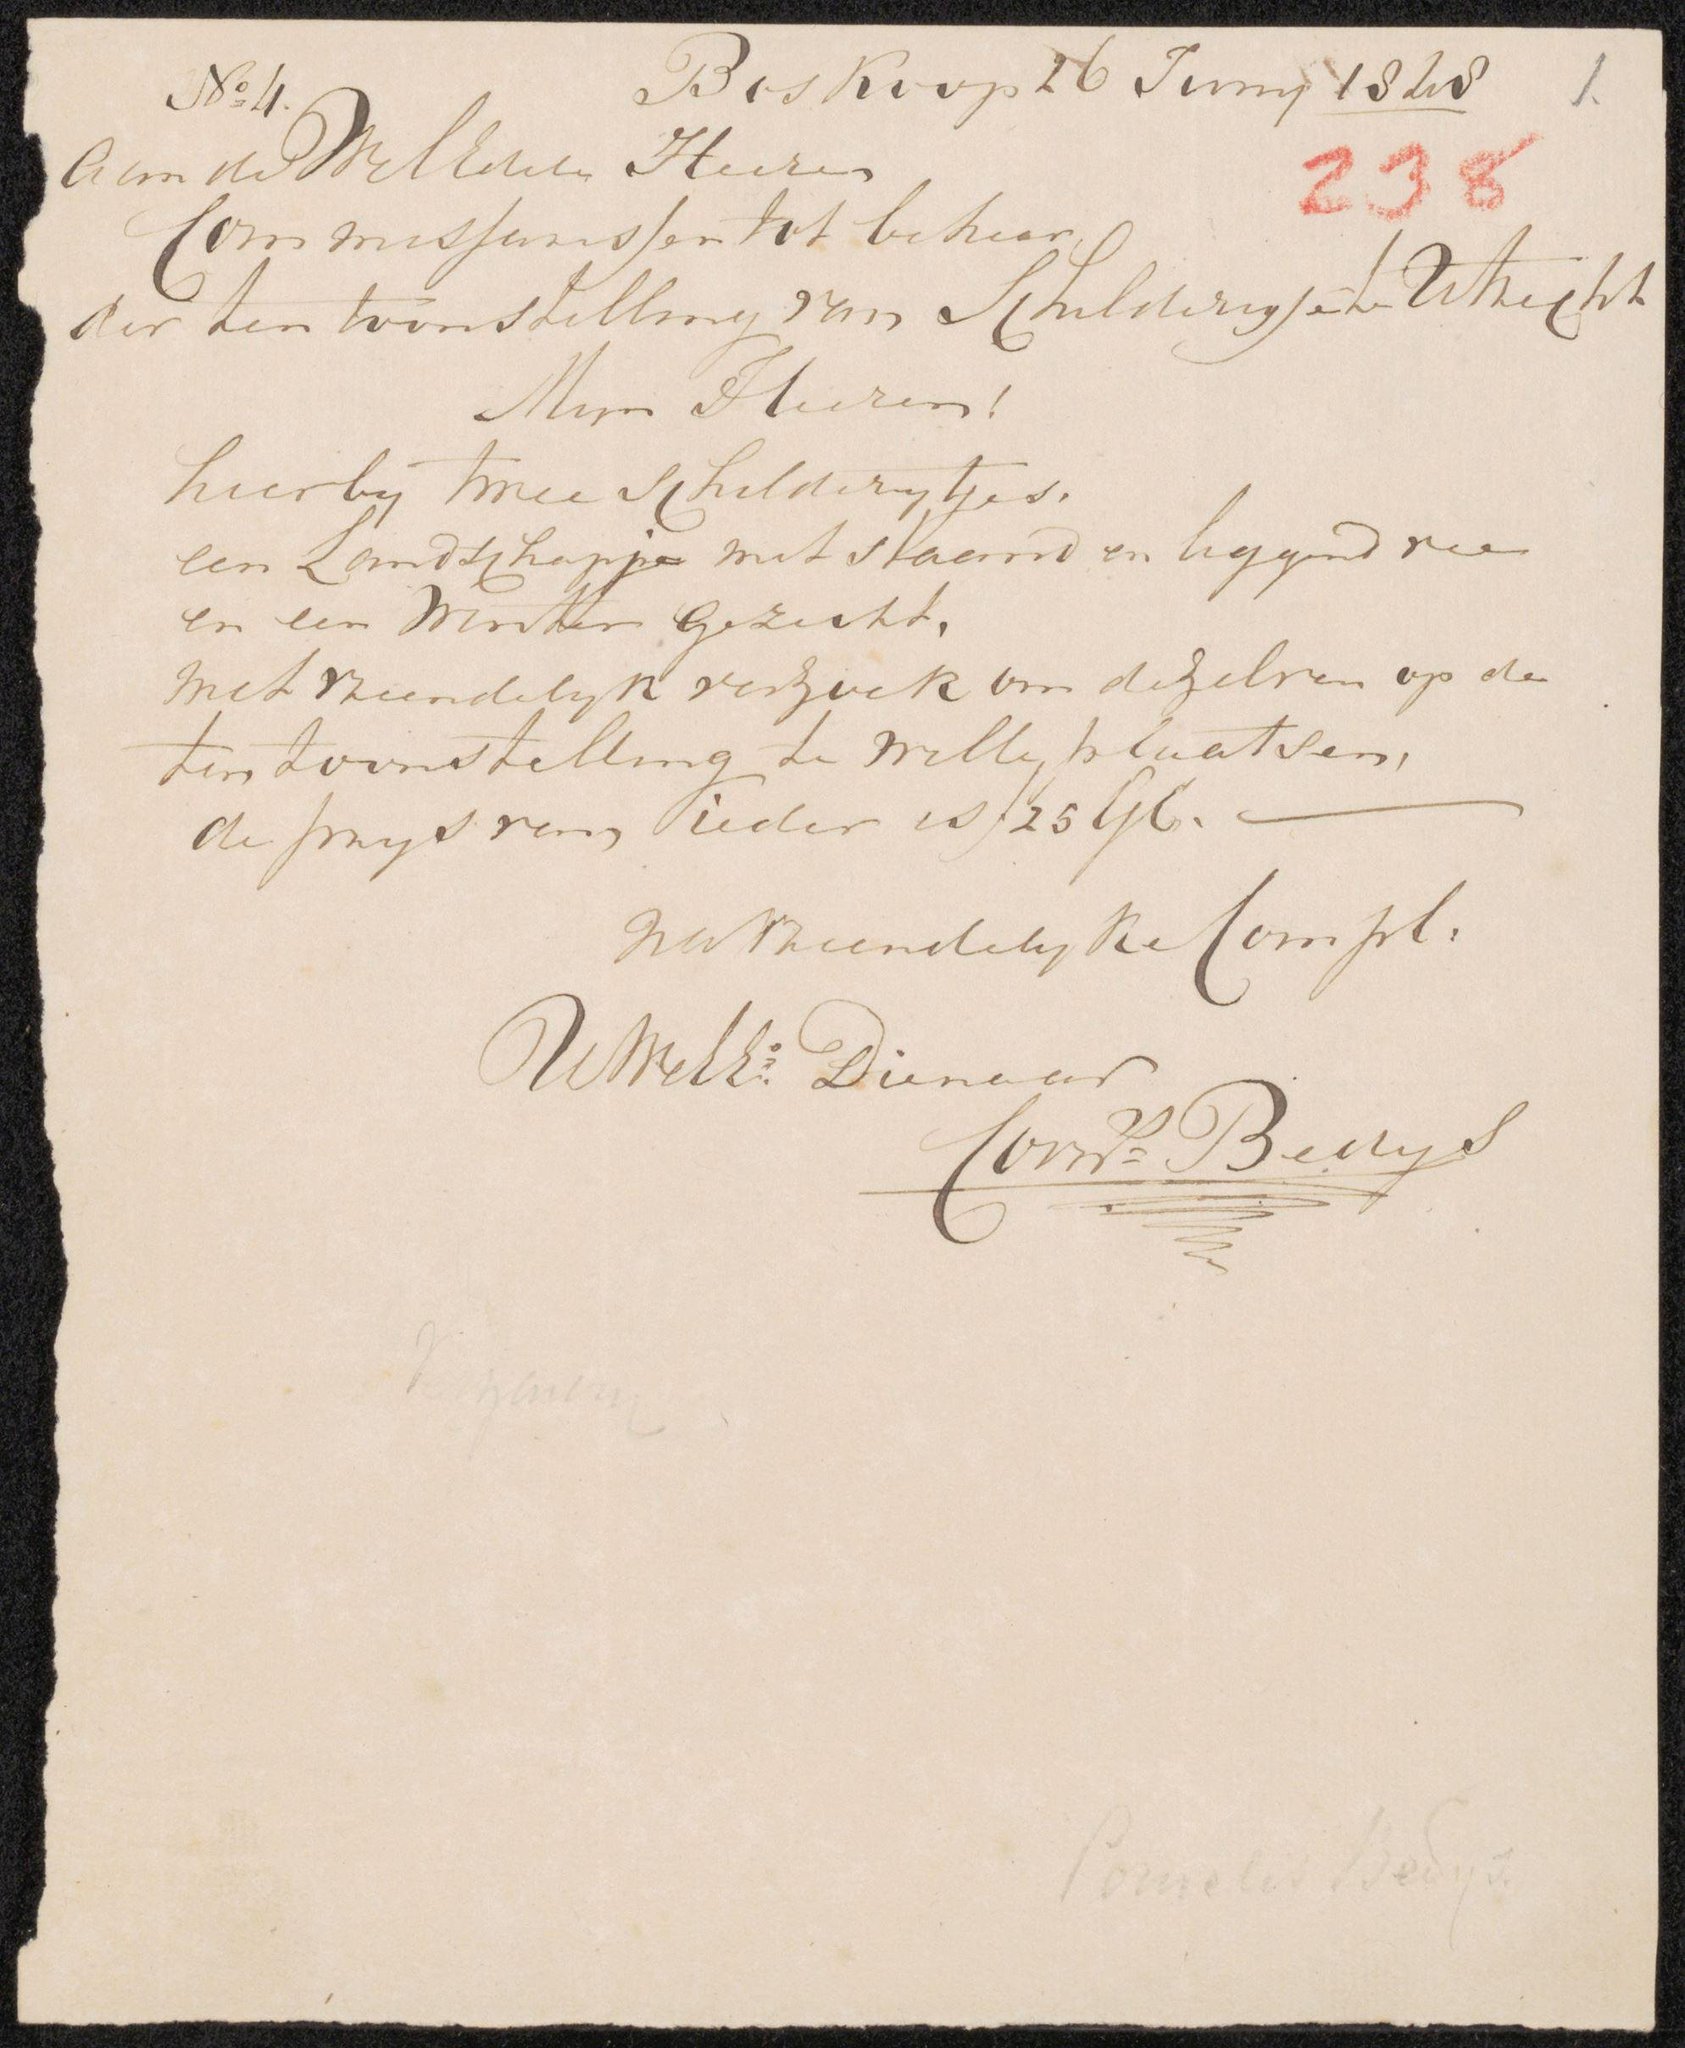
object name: letter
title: Brief aan de commissie van de Tentoonstelling van Levende Meesters in Utrecht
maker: cornelis bedijs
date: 1848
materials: ink, paper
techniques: pen, writing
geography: boskoop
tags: painting (including book-illumination, miniature-painting), exhibition ~ art, money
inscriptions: collector's mark: Lugt 2233